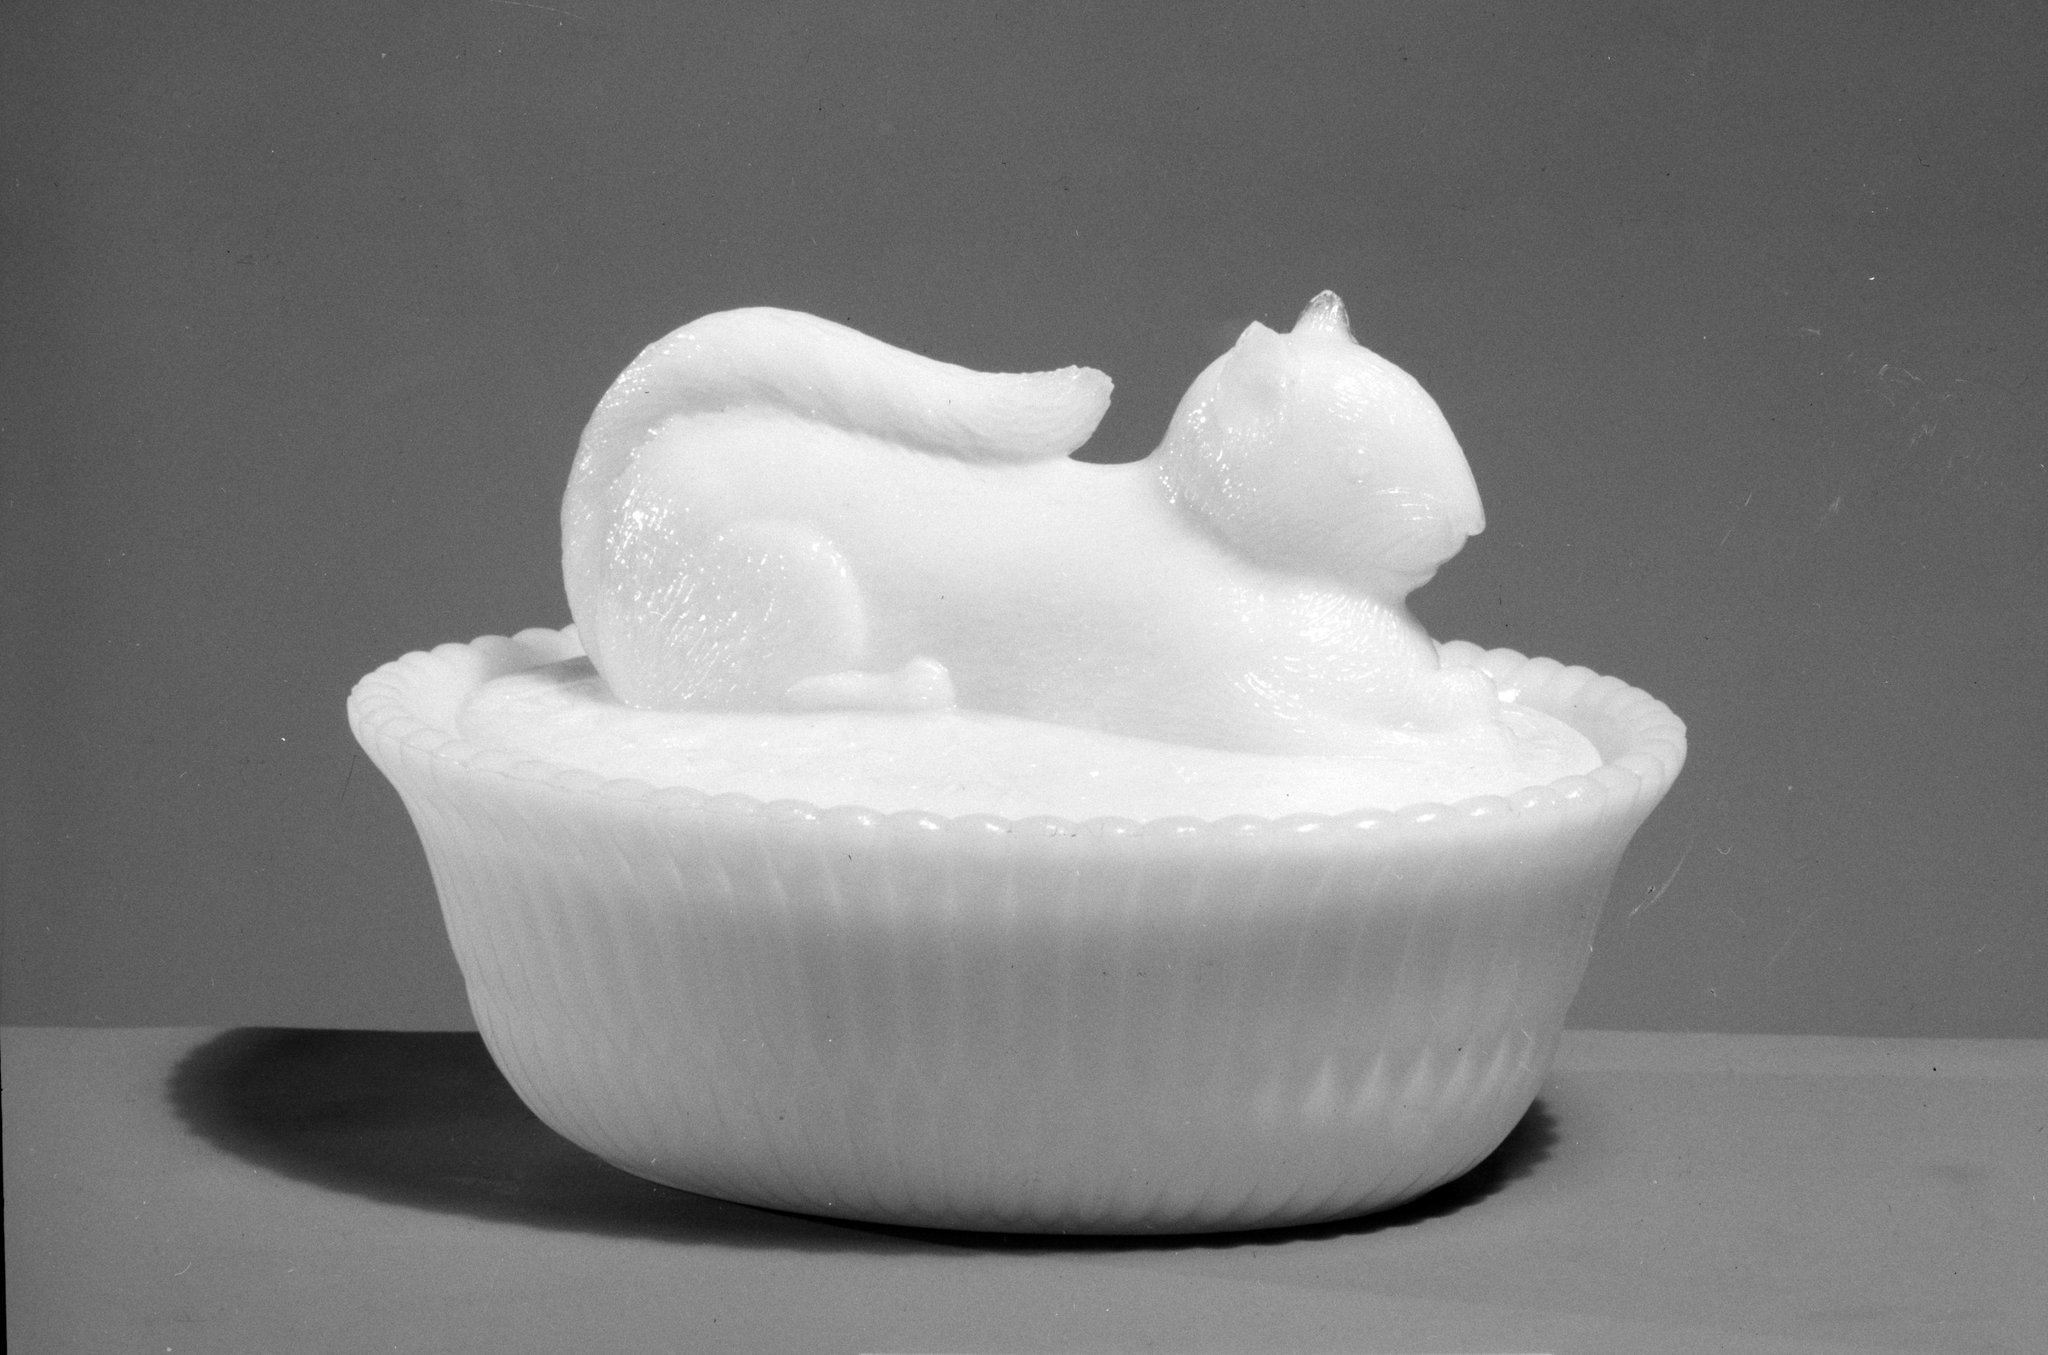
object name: dish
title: Figure Dish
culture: american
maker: mckee and brothers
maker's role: maker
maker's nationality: american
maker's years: 1856-1889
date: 1880-1890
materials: glass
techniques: pressed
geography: united states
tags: animals